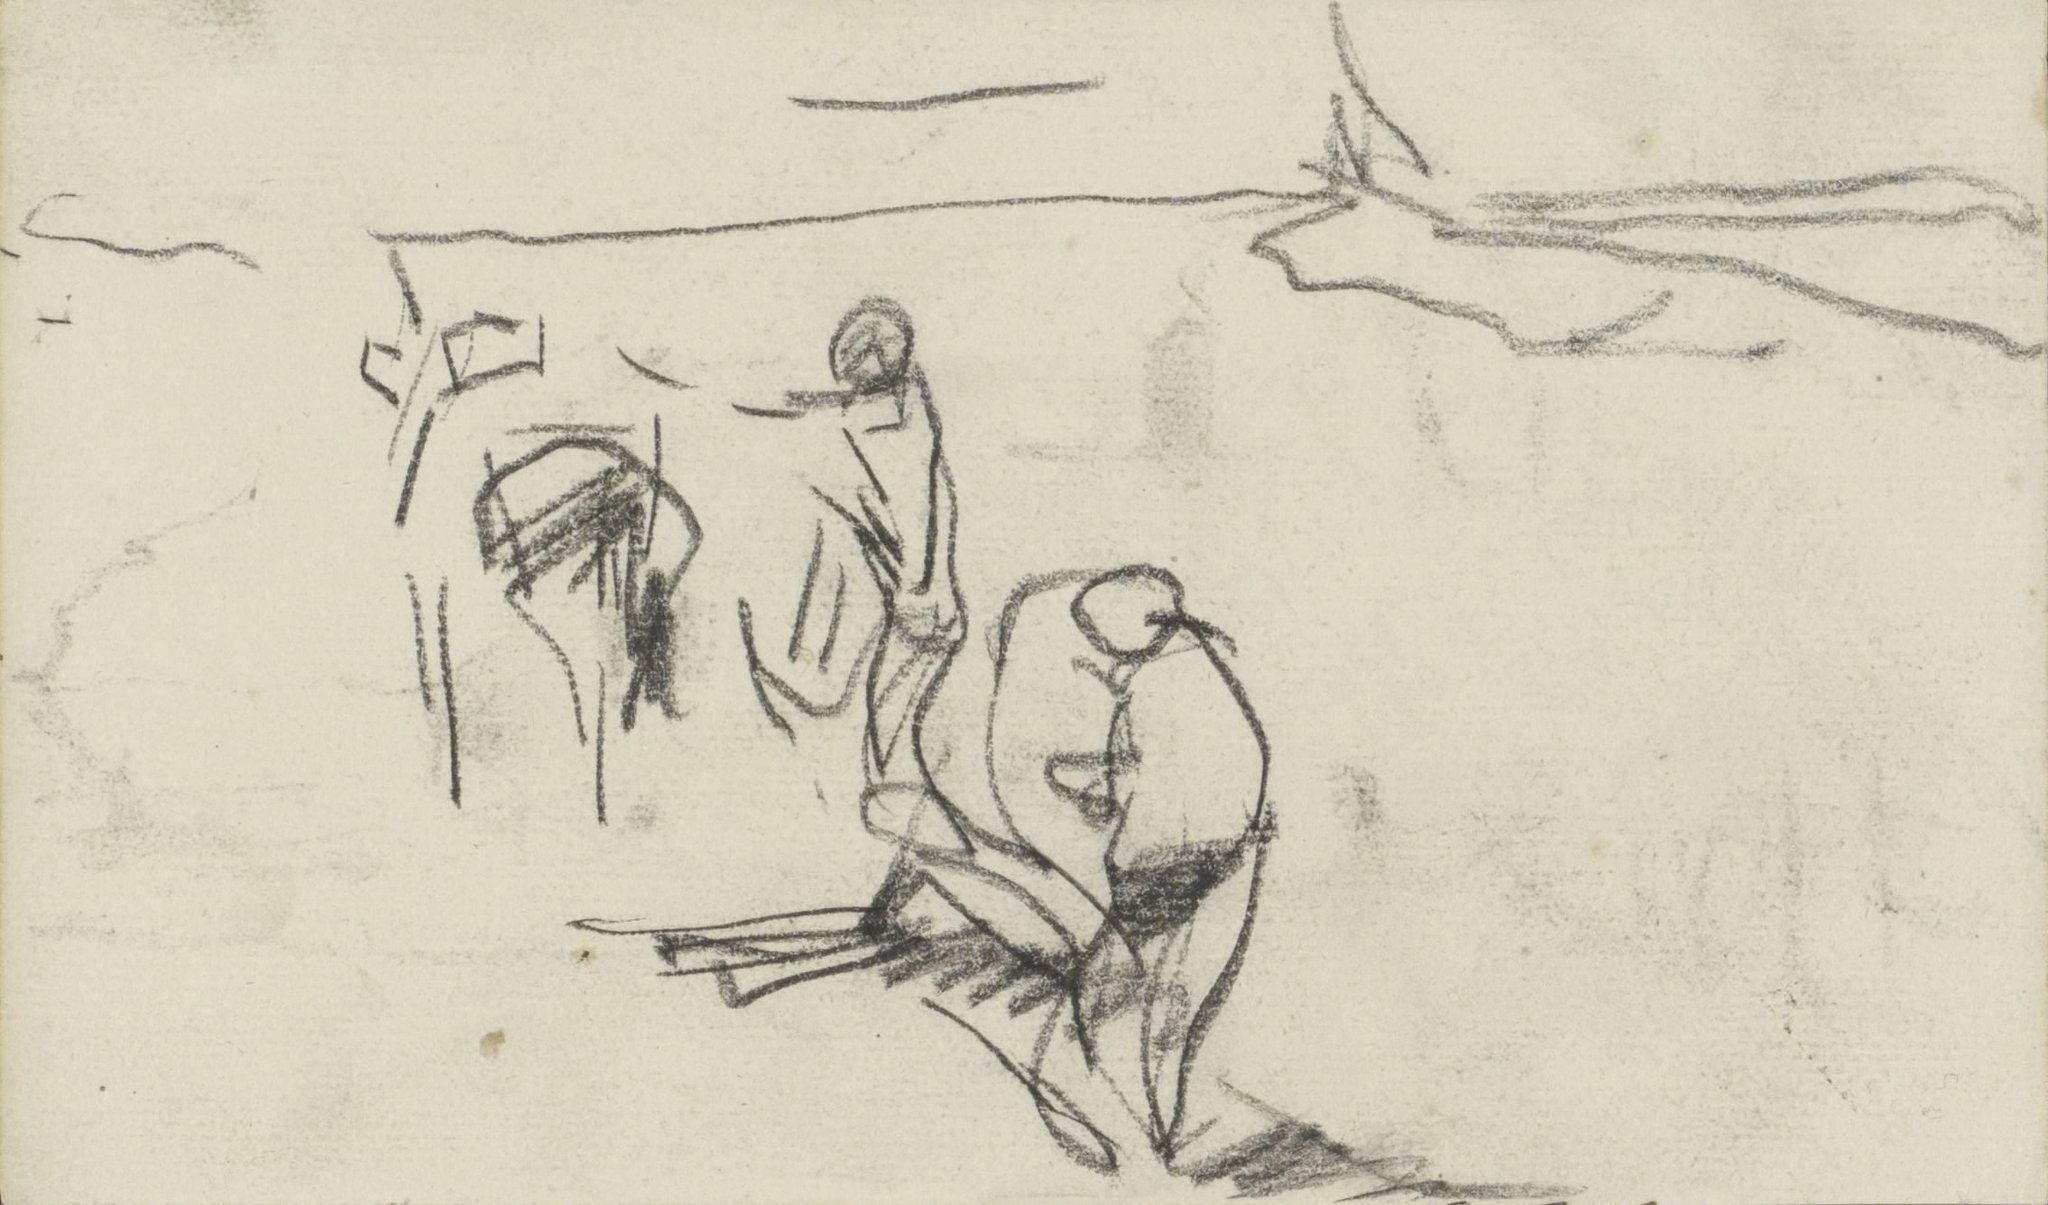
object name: drawing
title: Ploegende boeren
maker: george hendrik breitner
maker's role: draughtsman, painter, print maker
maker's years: 1857-1923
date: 1873-1886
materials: chalk, paper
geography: netherlands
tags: ploughing